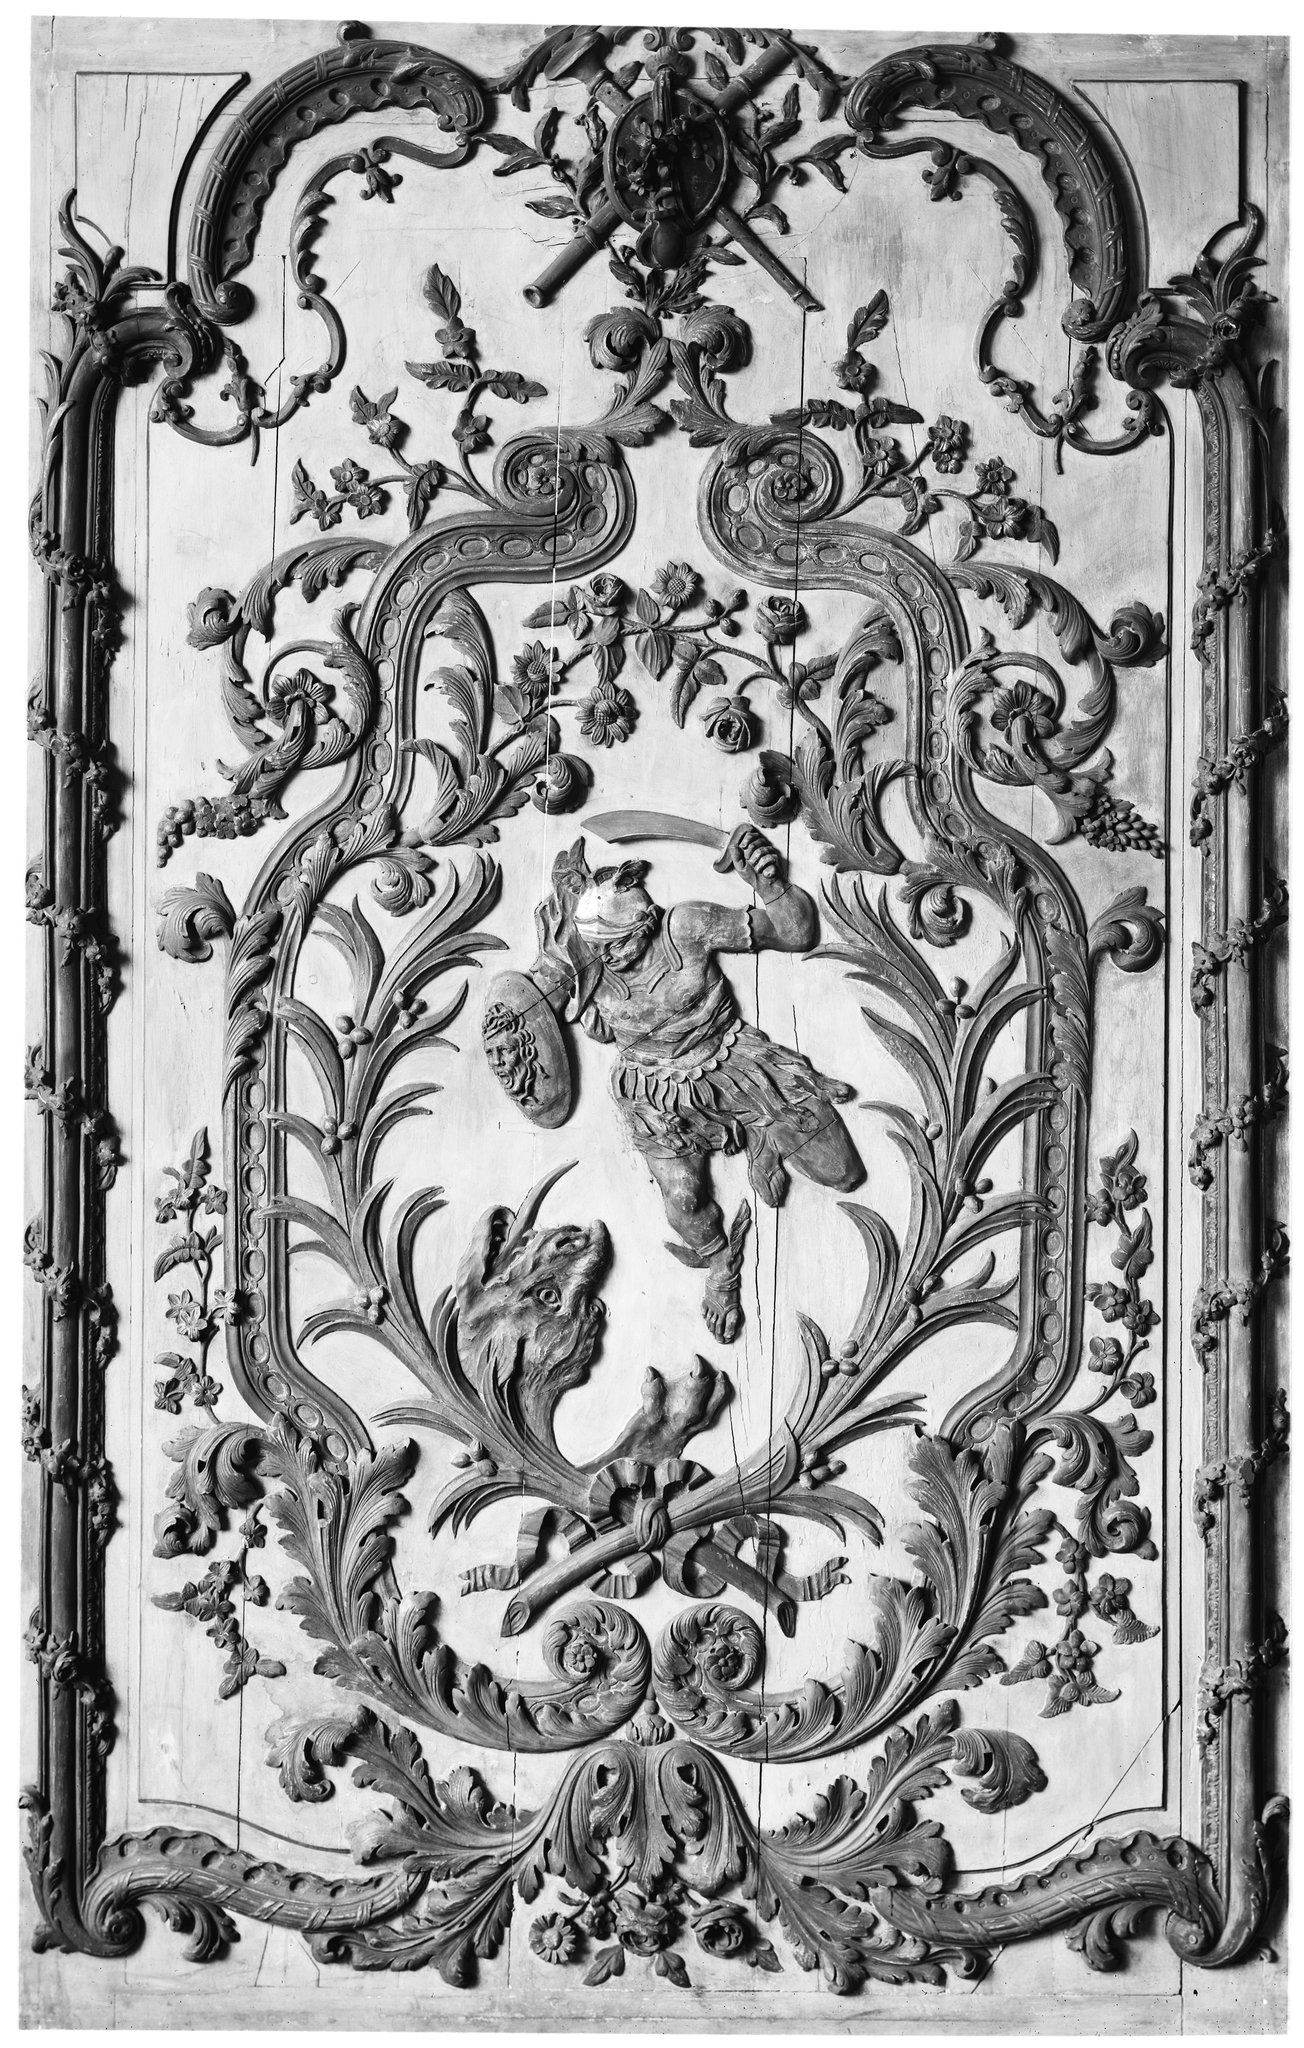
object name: panel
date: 1701-1800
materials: wood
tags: human figures,flowers,leaves